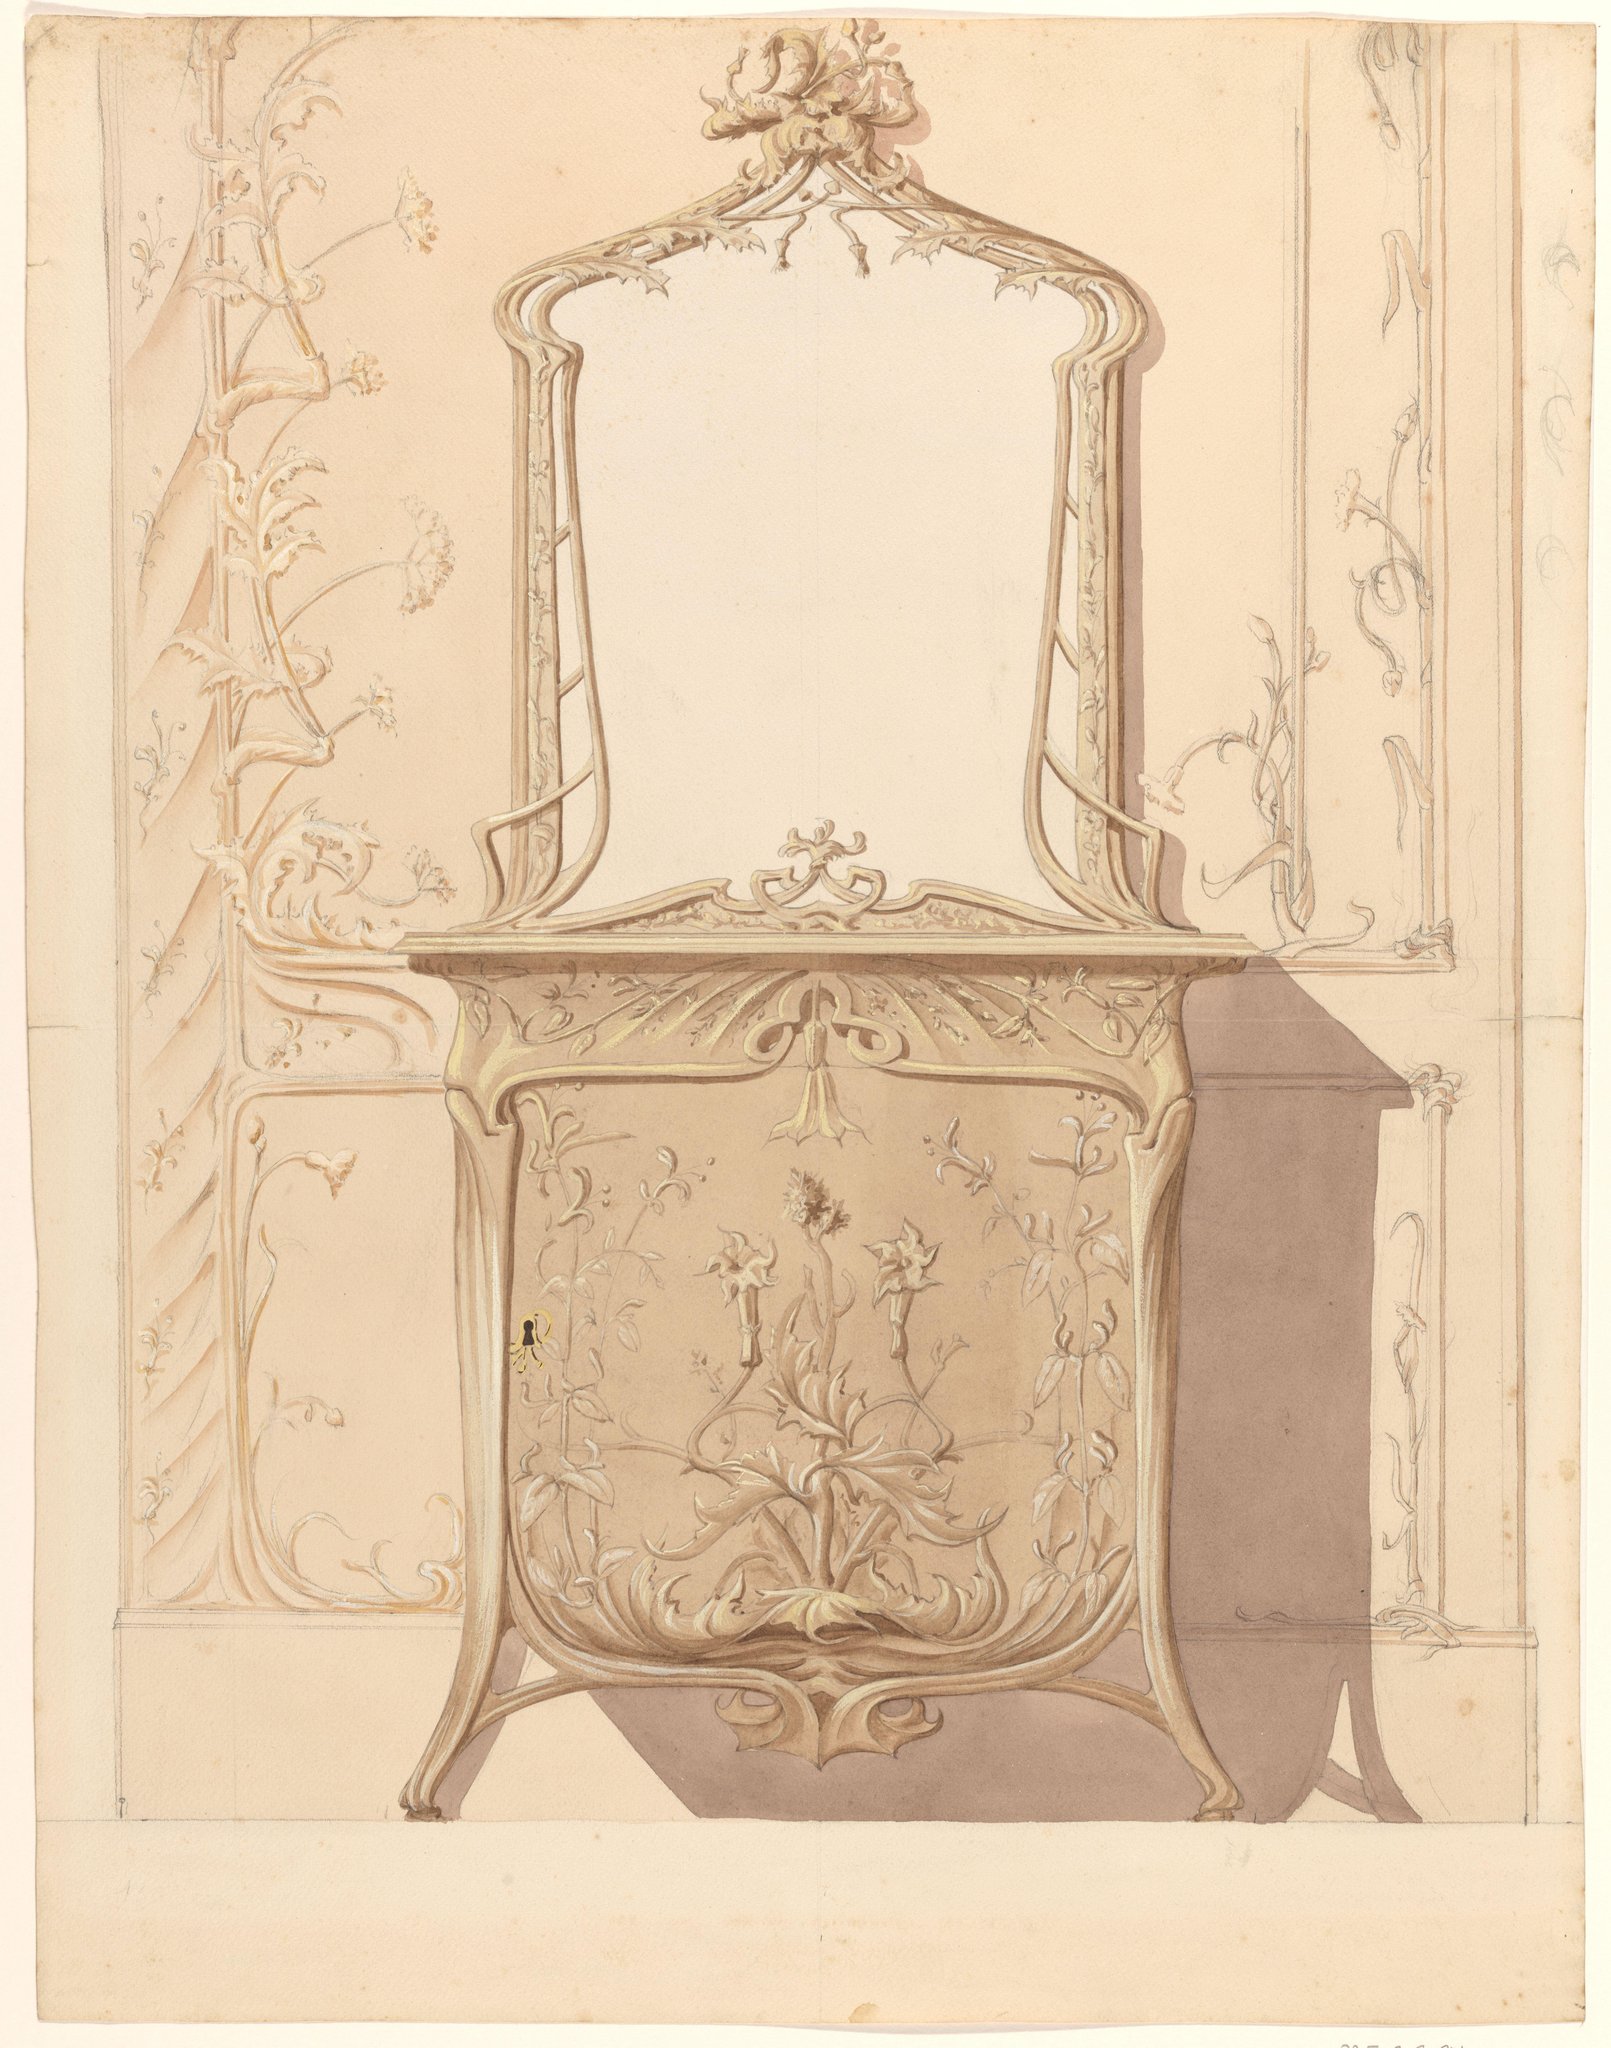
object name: drawing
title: Bergmeubel met spiegelopstand in florale art nouveau-stijl, staande tegen een wand die in dezelfde stijl is gedecoreerd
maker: Anonymous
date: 1895-1910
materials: chalk, graphite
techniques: brush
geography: paris